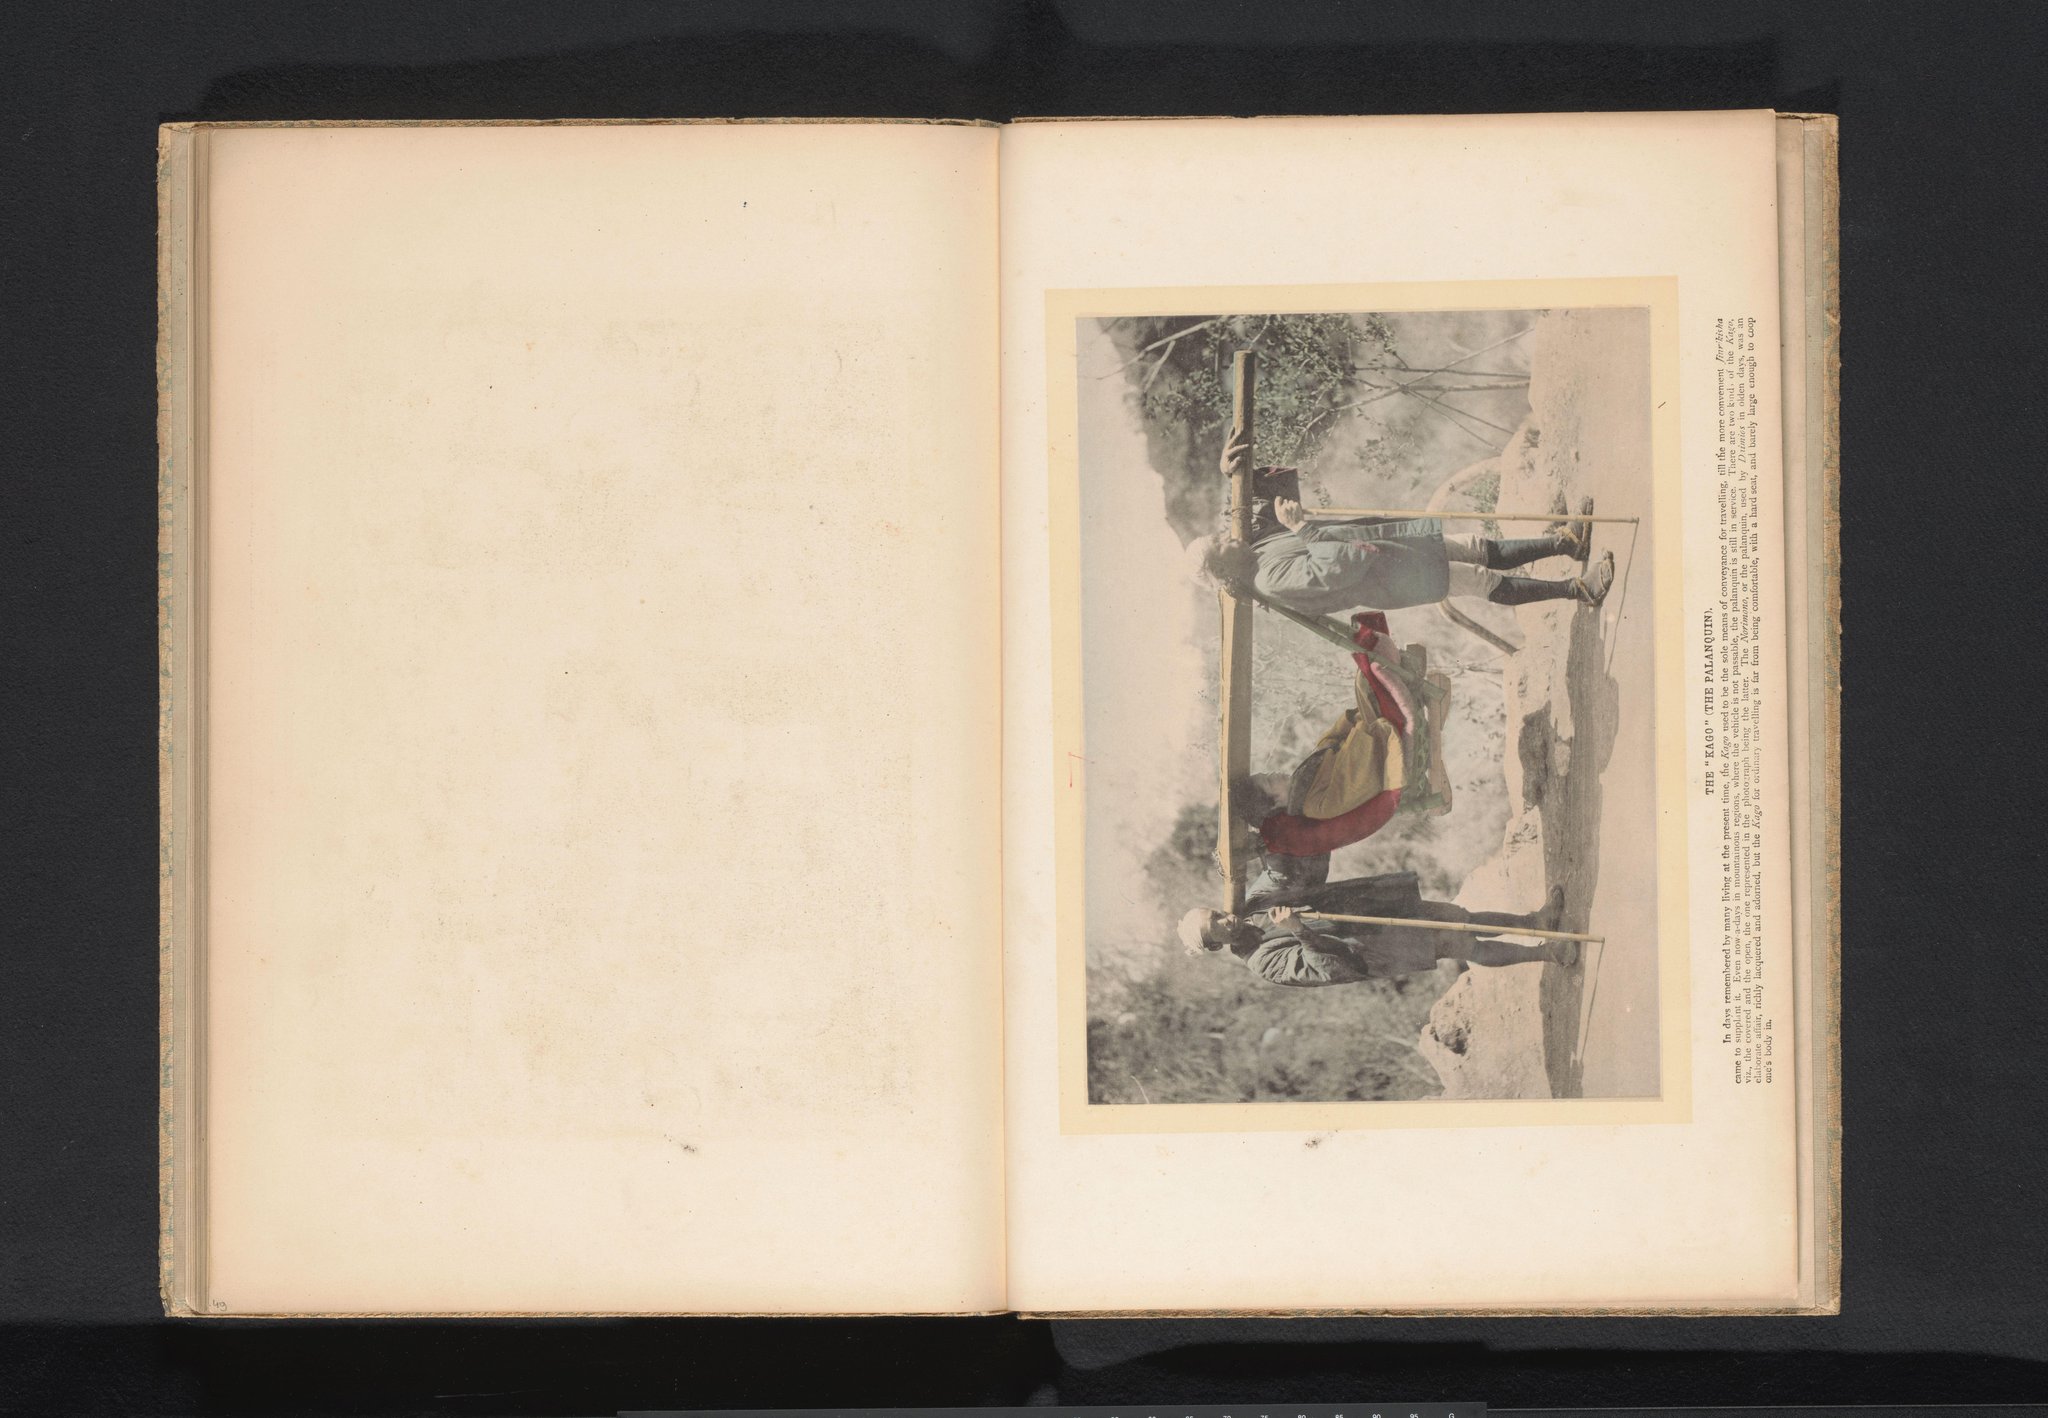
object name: page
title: Vrouw in een draagstoel, gedragen door twee mannen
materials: paper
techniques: photograph, lithograph, hand coloring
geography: japan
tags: adult man (+ two persons), (carrying a person on a) litter, stretcher, adult woman, japan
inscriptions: inscription: ‘In days (...) body in.’